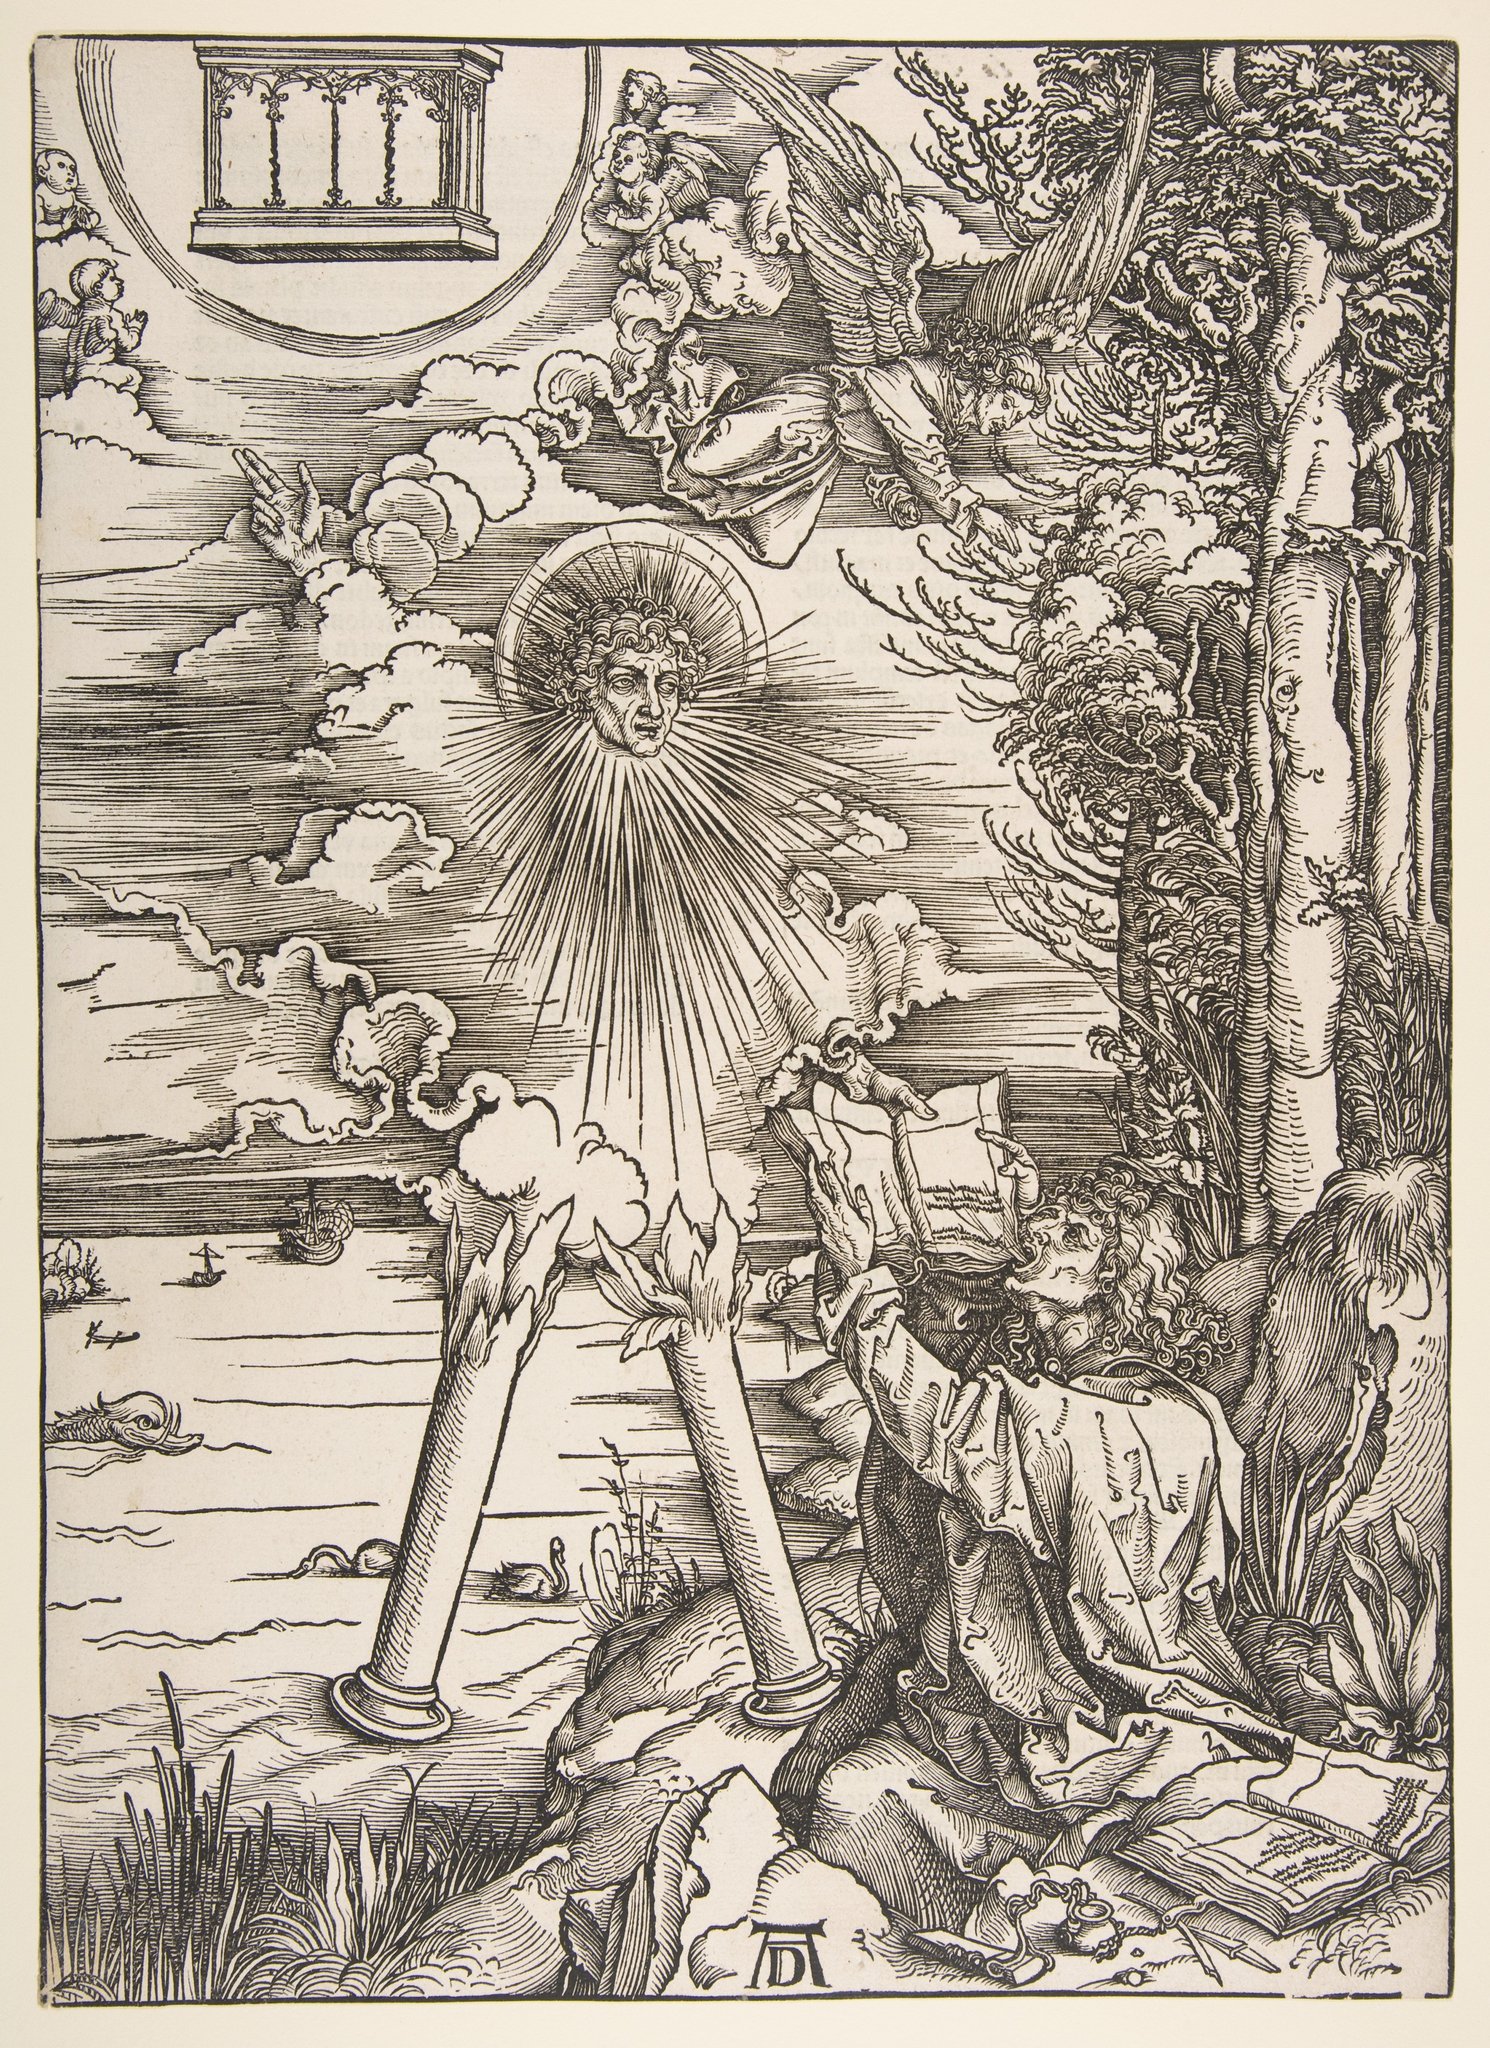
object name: print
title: Saint John Devouring the Book, from "The Apocalypse"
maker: albrecht dürer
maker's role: artist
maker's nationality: german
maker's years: 1471-1528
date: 1497-1498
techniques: woodcut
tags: saint john the baptist